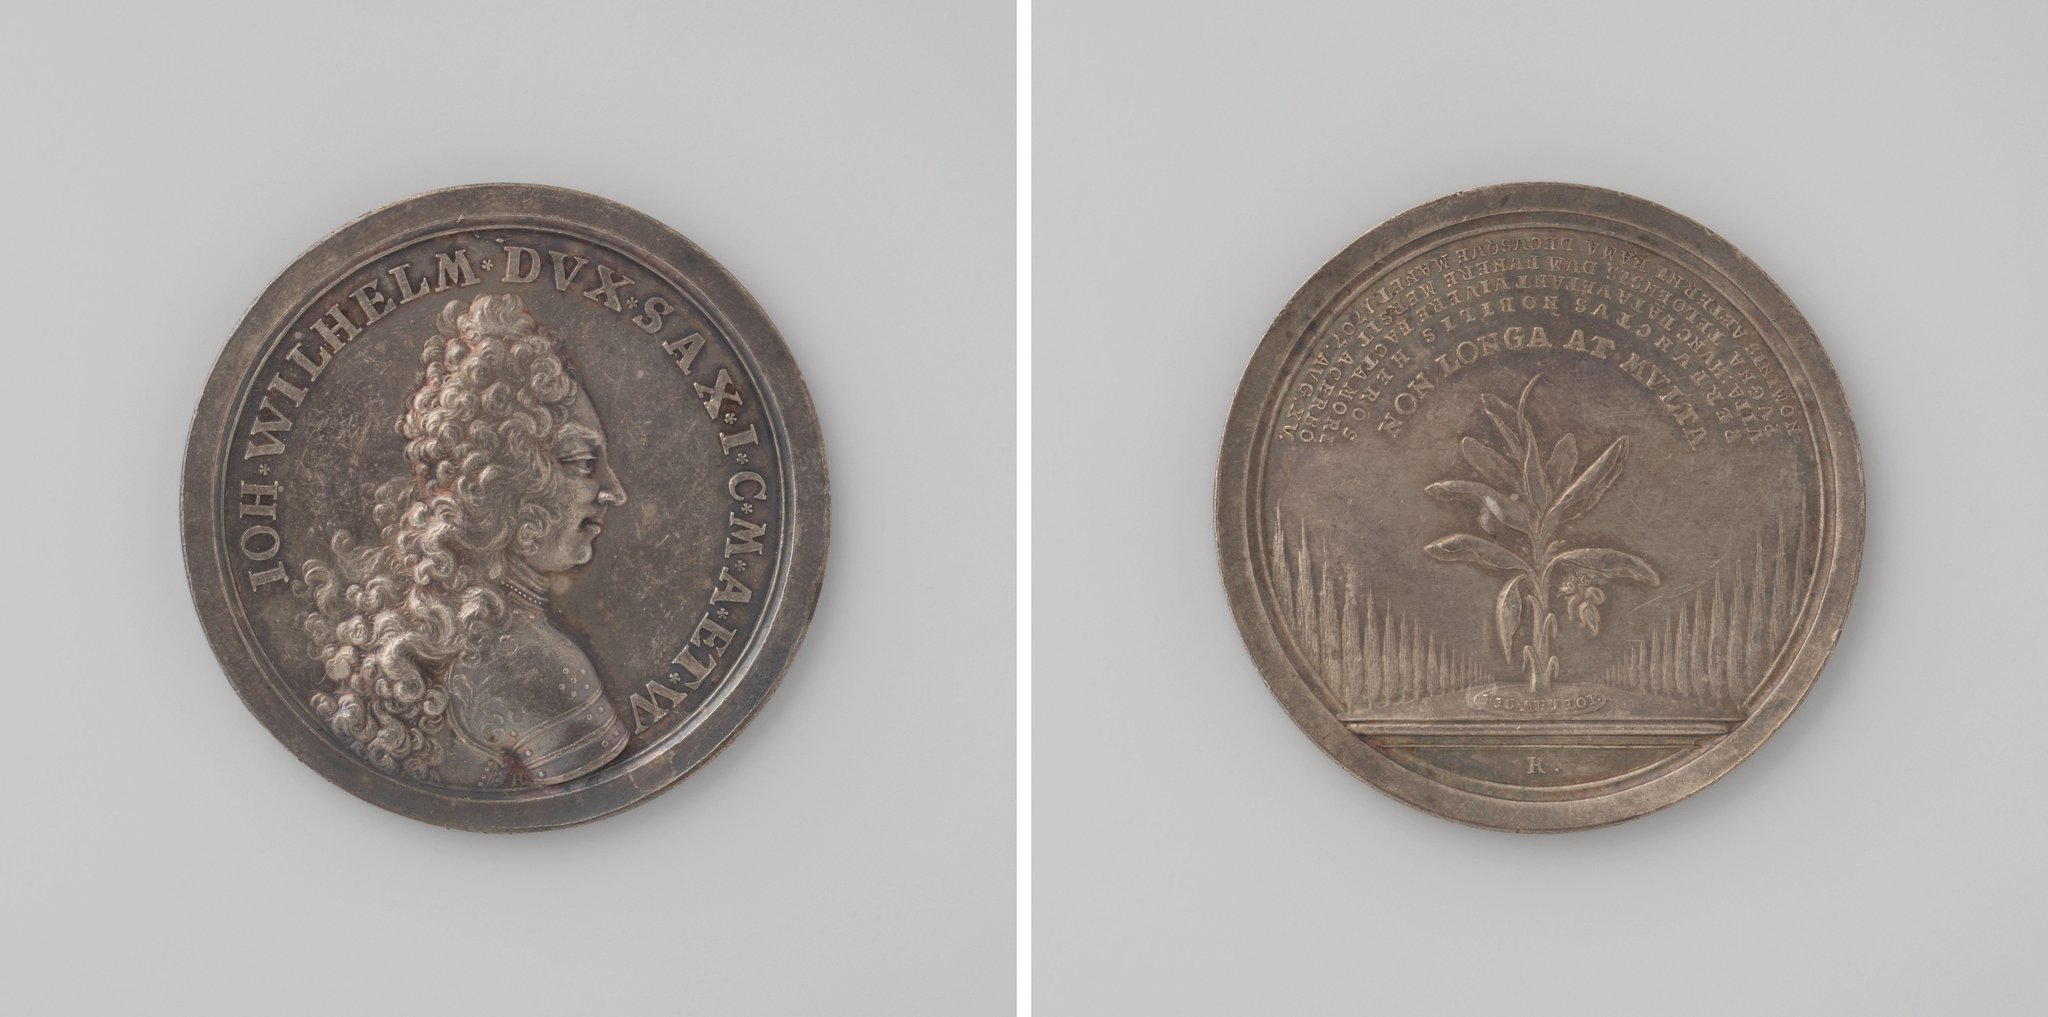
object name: history medal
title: Johann Willem, hertog van Saksen-Gotha sneuvelt bij Toulon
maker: johann christian koch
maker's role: mintmaster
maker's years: 1680-1742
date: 1707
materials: silver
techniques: striking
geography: gotha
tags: toulon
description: Zilveren penning. Voorzijde: borststuk man binnen omschrift. Keerzijde: Ethiopisch gewas temidden van twee rijen bomen onder vijfregelig opschrift; afsnede: signatuur